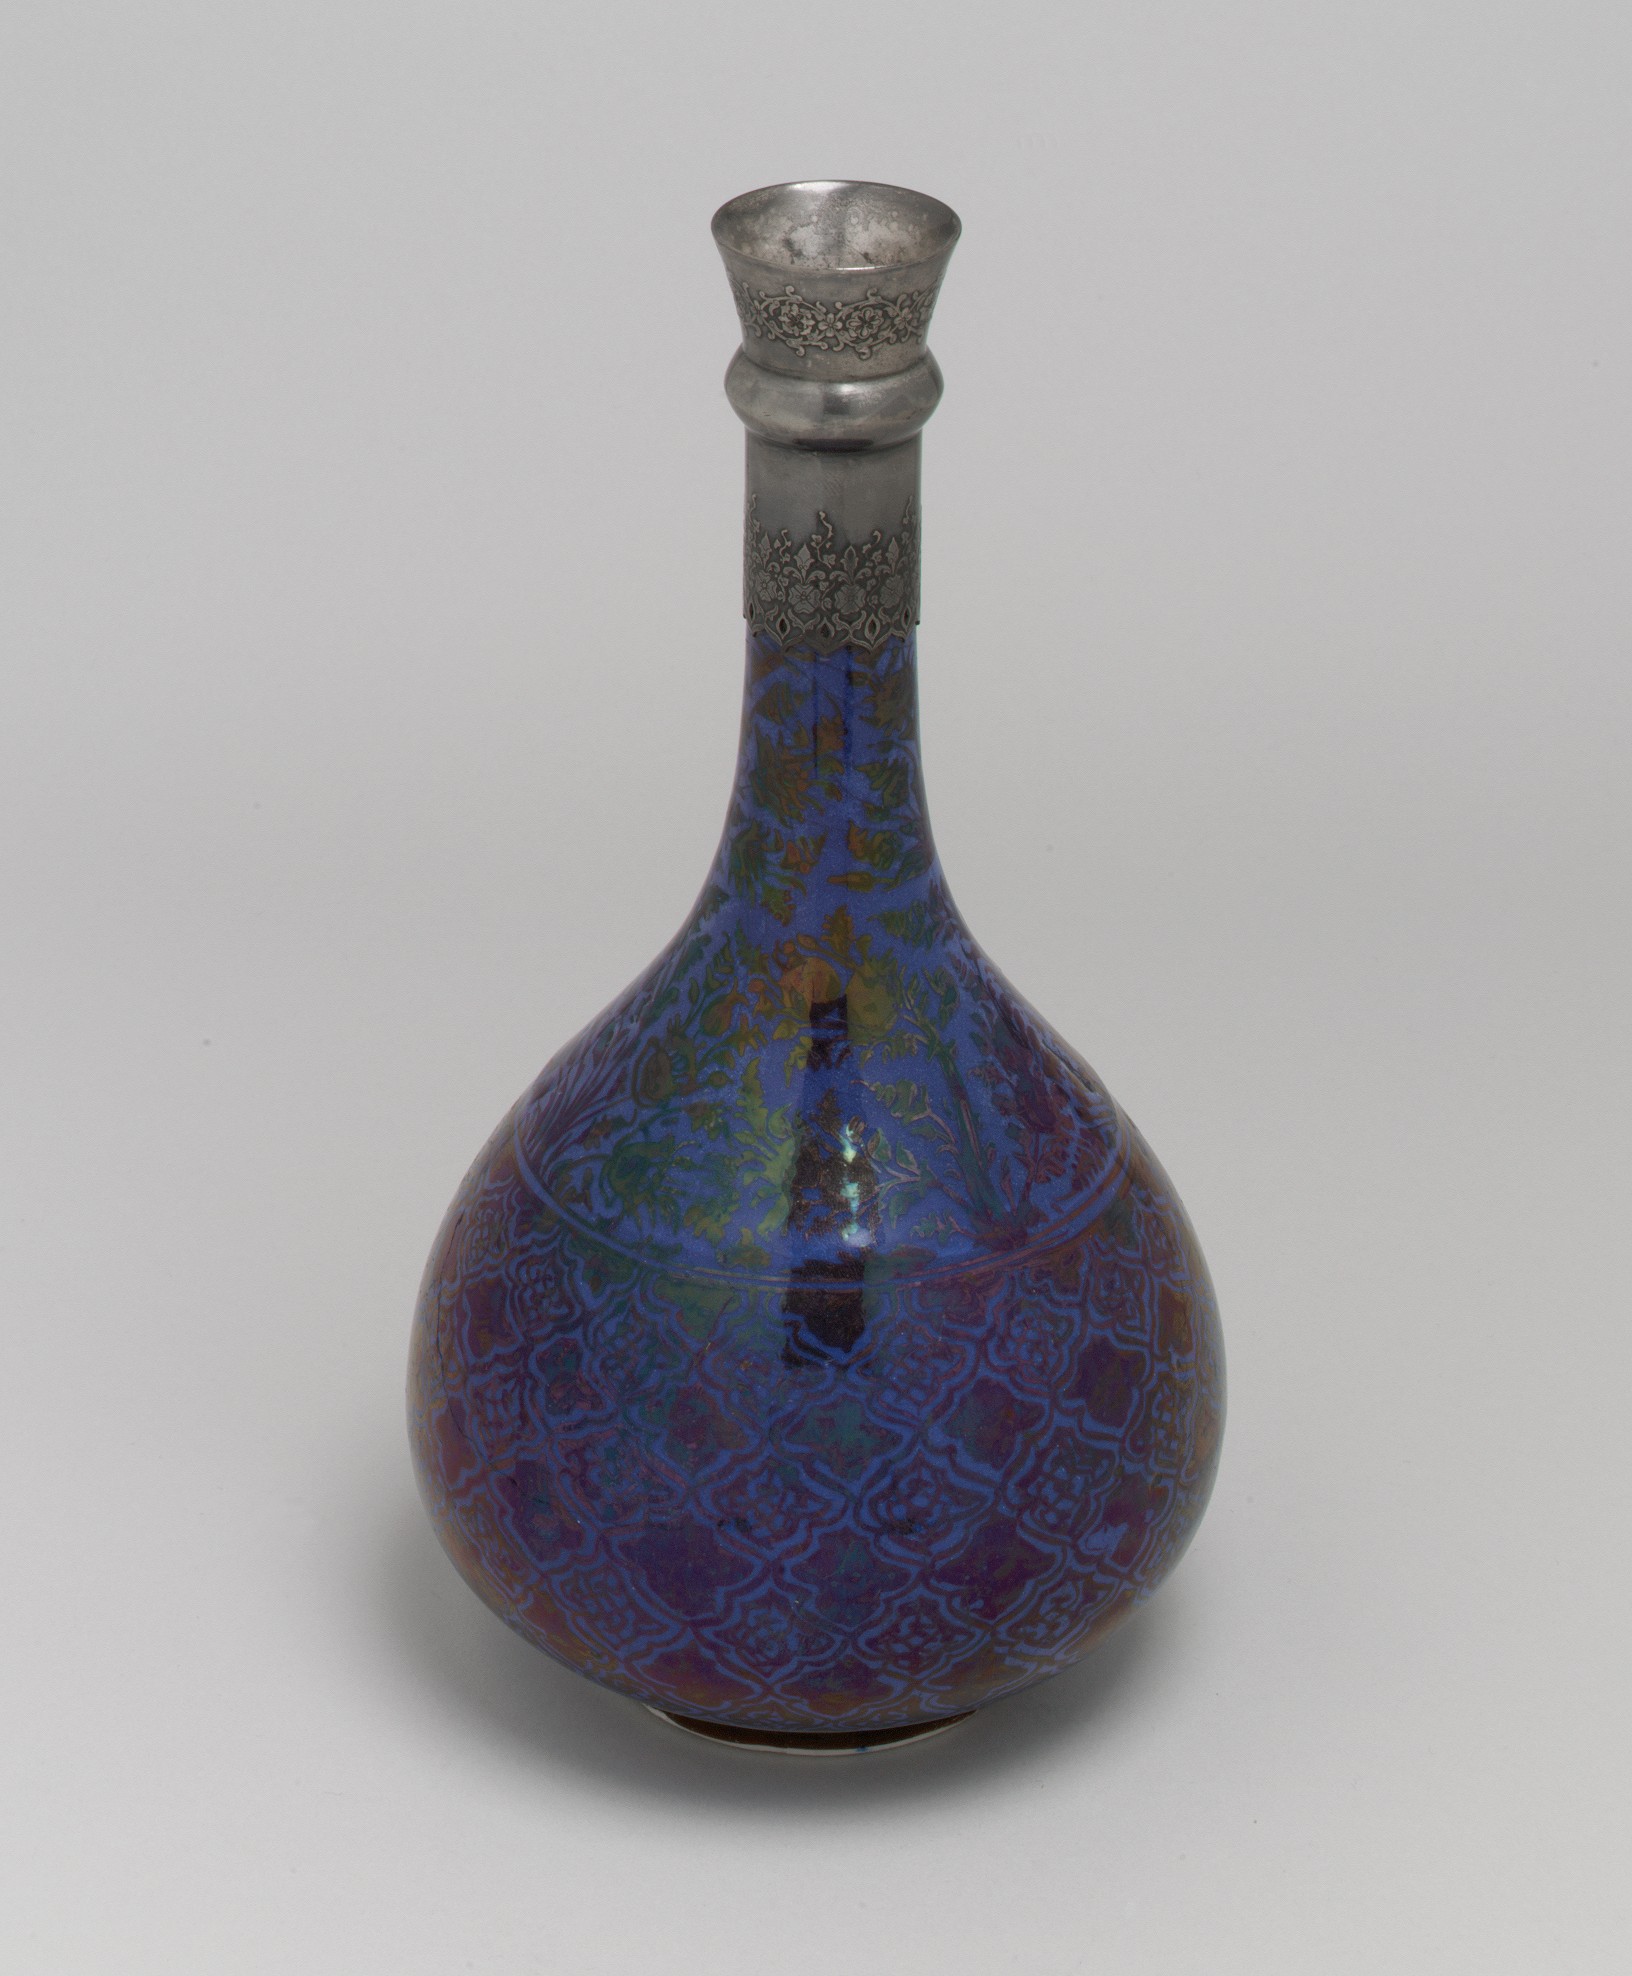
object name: bottle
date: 1601-1700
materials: glaze, silver, stonepaste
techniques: luster painting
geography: iran